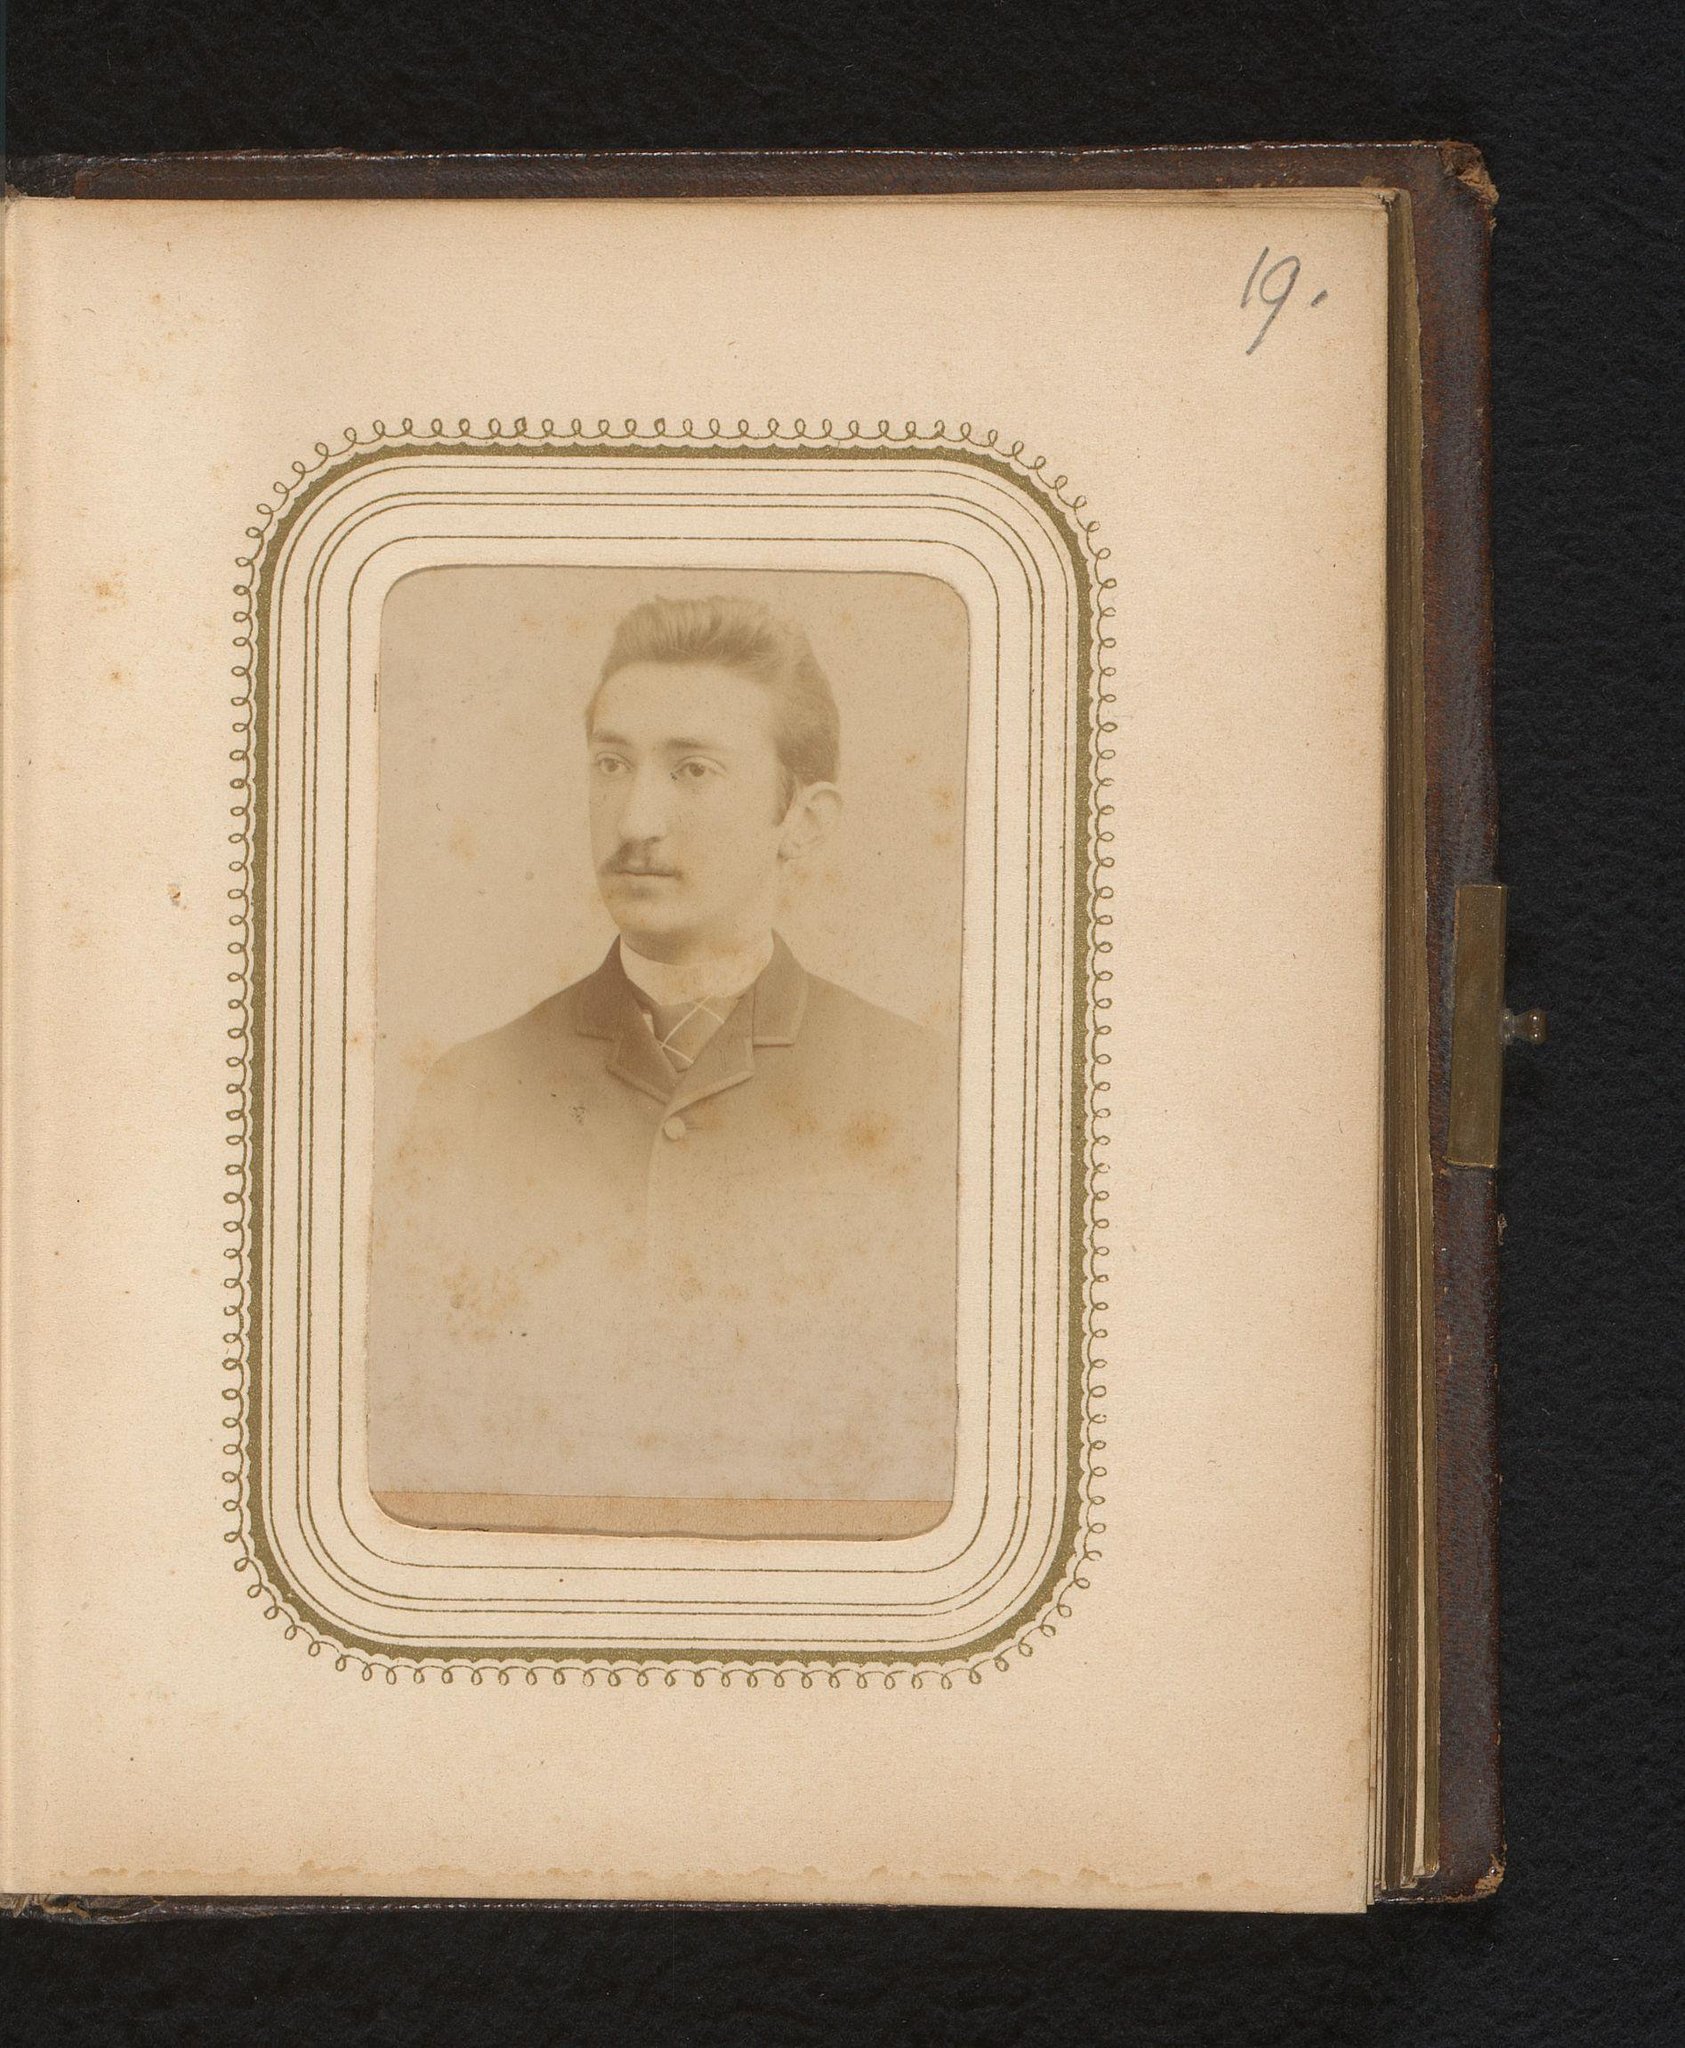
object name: photograph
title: Portret van François Buys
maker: max büttinghausen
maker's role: fotograaf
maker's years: 1847-1906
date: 1886-1906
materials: cardboard, paper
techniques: albumen print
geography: amsterdam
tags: françois buys, historical persons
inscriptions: inscription: ‘M. Büttinghausen/ Photographisch artistisch Atelier/ Amsterdam/ Kalverstraat/ hoek Spui (...)’, inscription: ‘M. Büttinghausen Amsterdam’